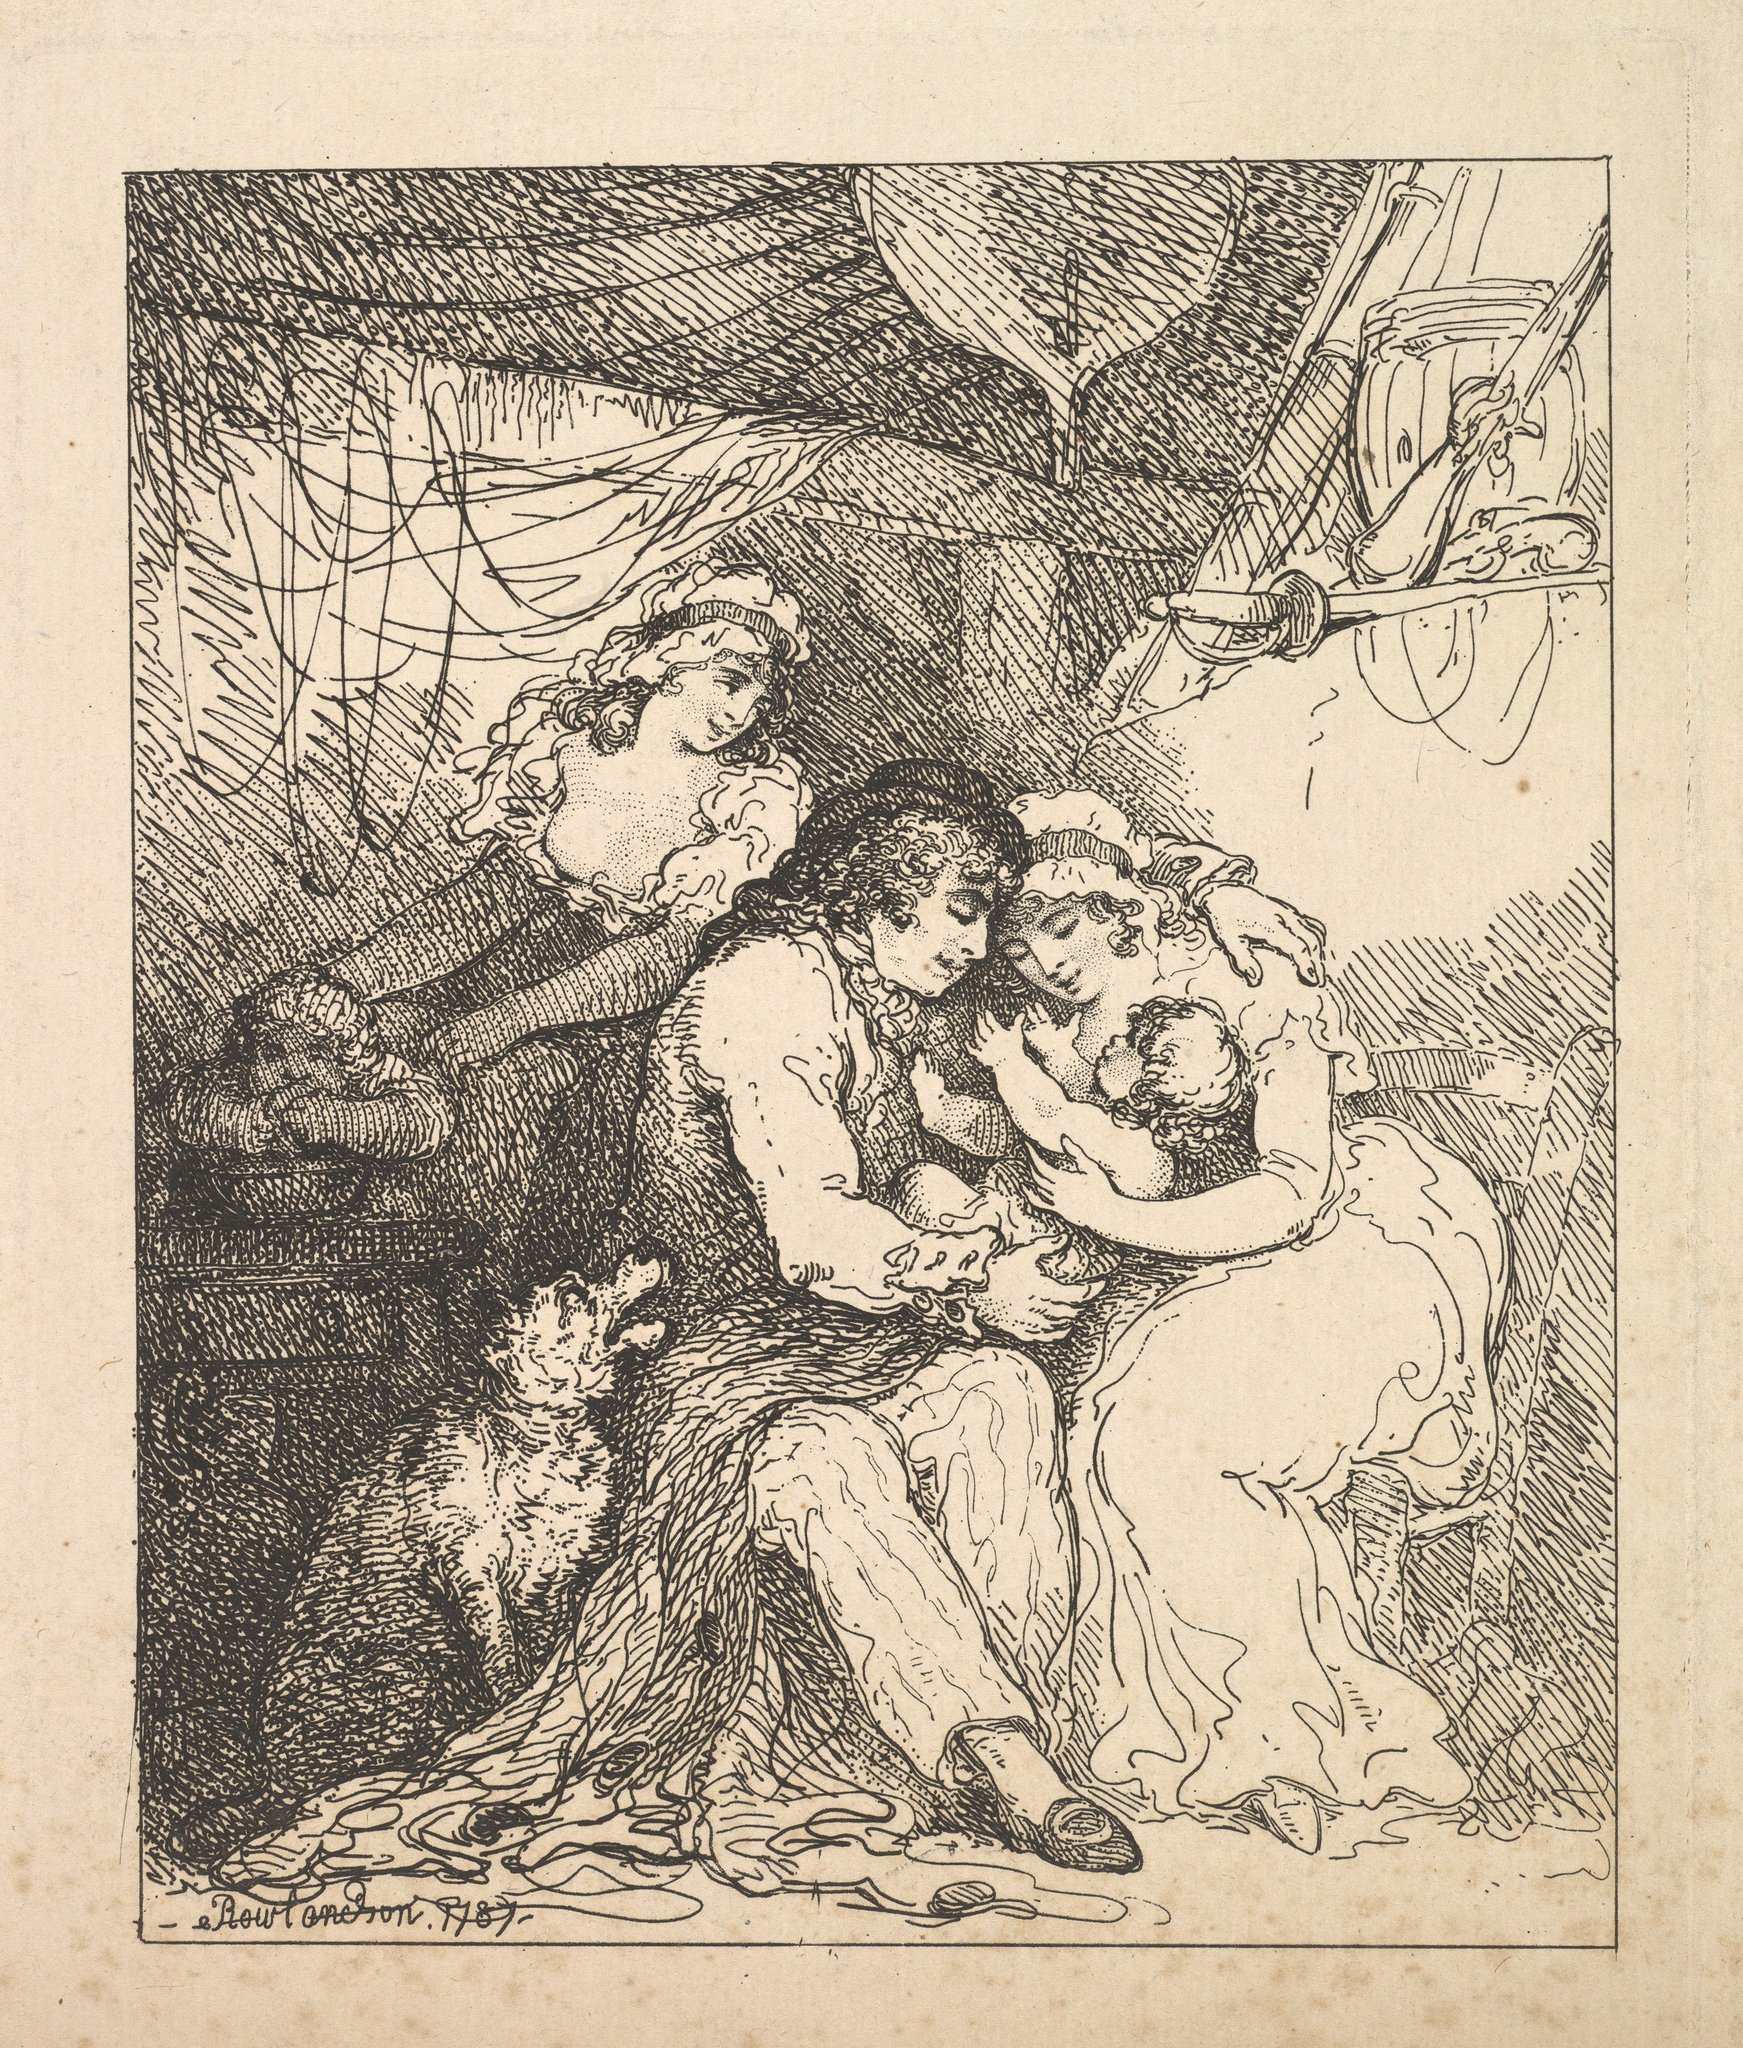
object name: print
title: A Sailor's Family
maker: thomas rowlandson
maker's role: artist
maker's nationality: british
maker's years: 1757-1827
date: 1787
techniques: etching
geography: england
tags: interiors,weapons,infants,men,women,dogs,family,sailors